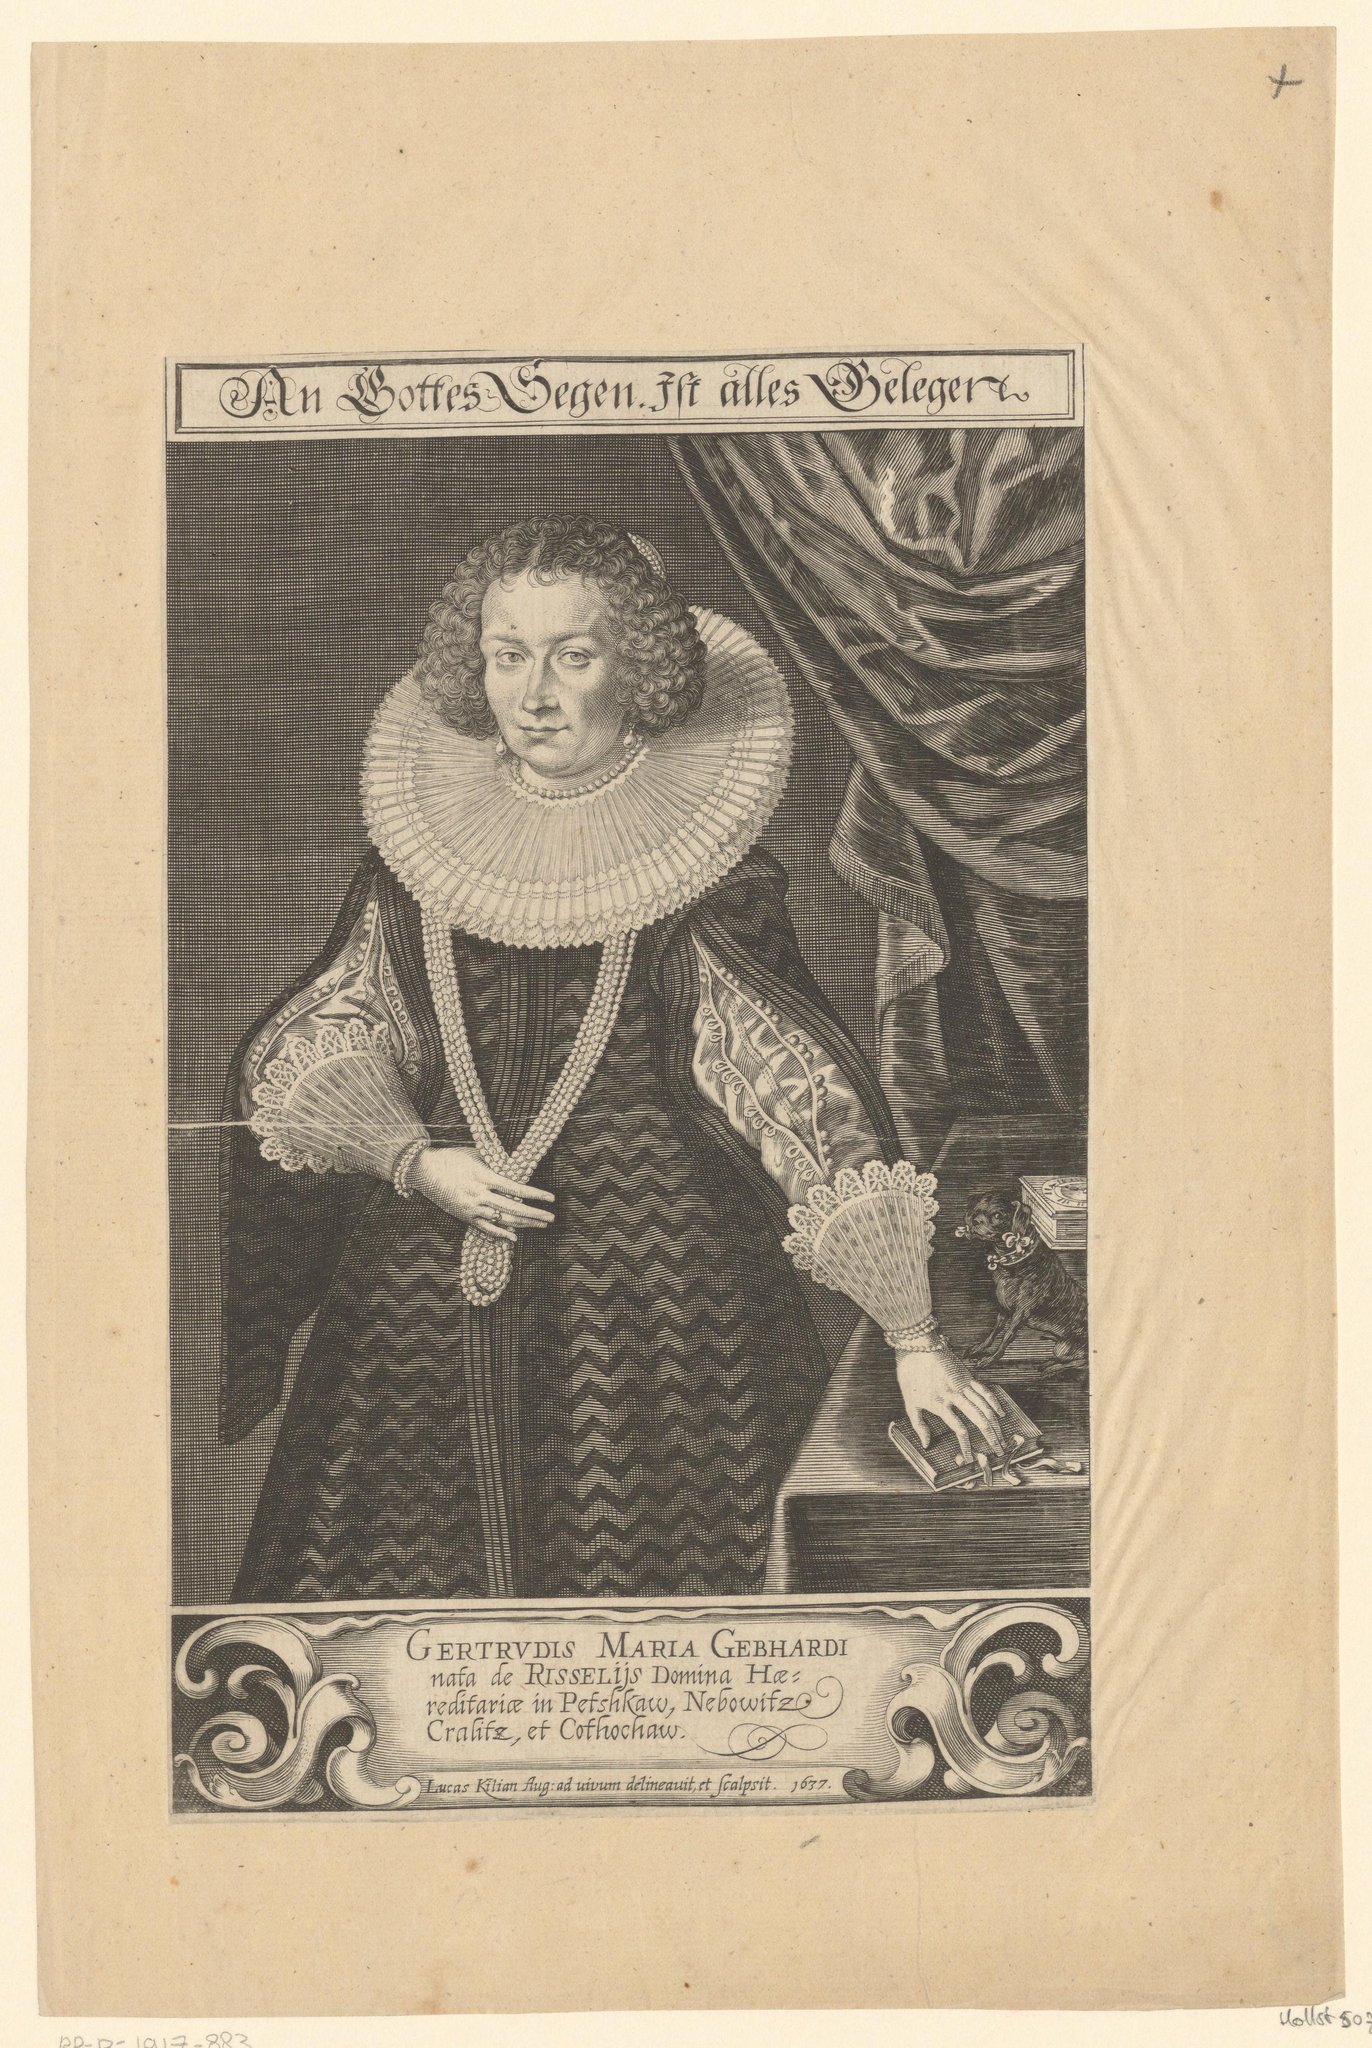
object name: print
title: Portret van Gertrud Maria Rissel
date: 1637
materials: paper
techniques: engraving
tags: historical persons, pearl; pearl necklace, dog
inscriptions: collector's mark: Lugt 2228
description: Tekst in het Latijn in de bovenmarge en in de cartouche.